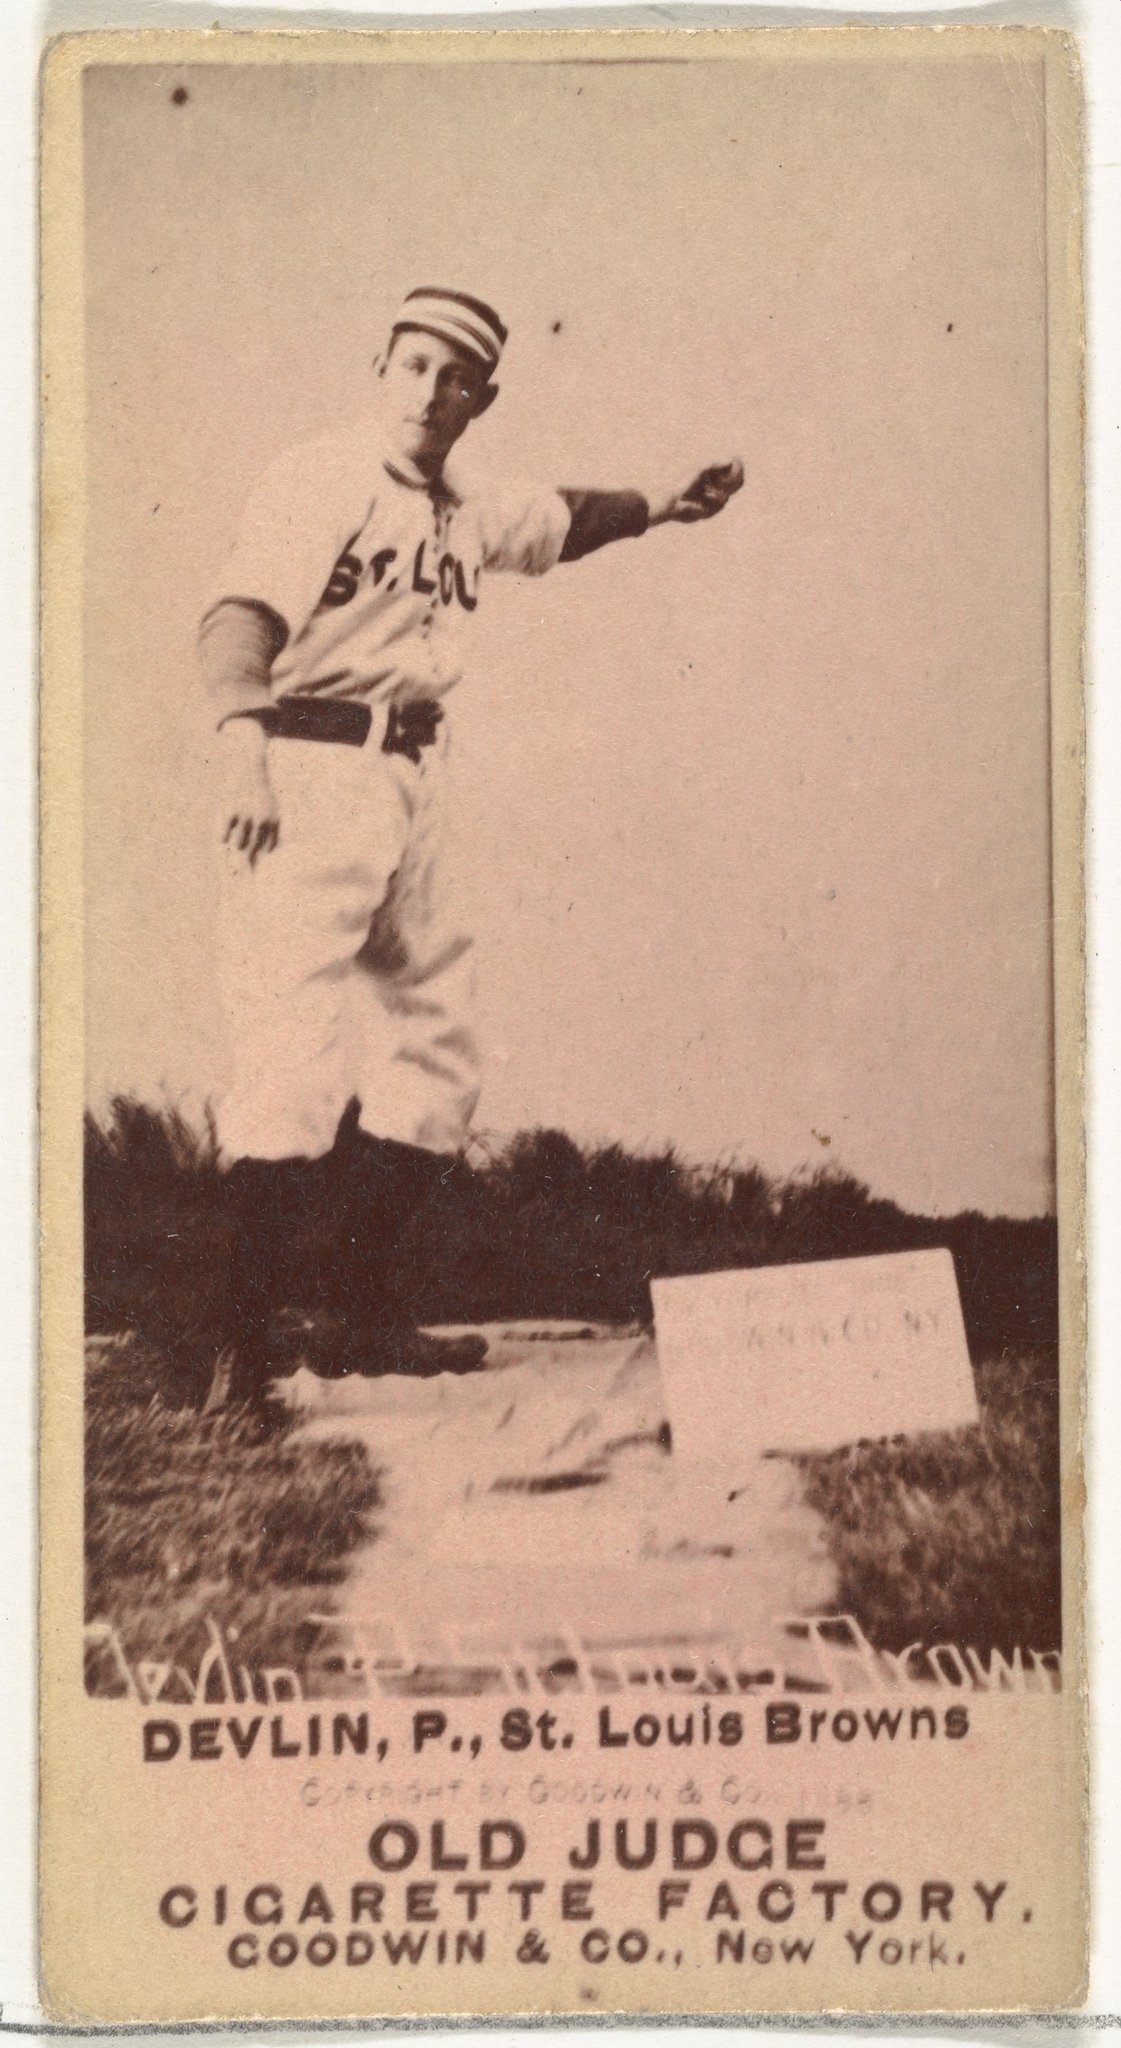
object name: baseball card, photograph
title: James H. "Jim" Devlin, Pitcher, St. Louis Browns, from the Old Judge series (N172) for Old Judge Cigarettes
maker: goodwin & company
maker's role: publisher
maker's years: 1850-1950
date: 1888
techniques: albumen silver print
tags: men,portraits,baseball,athletes